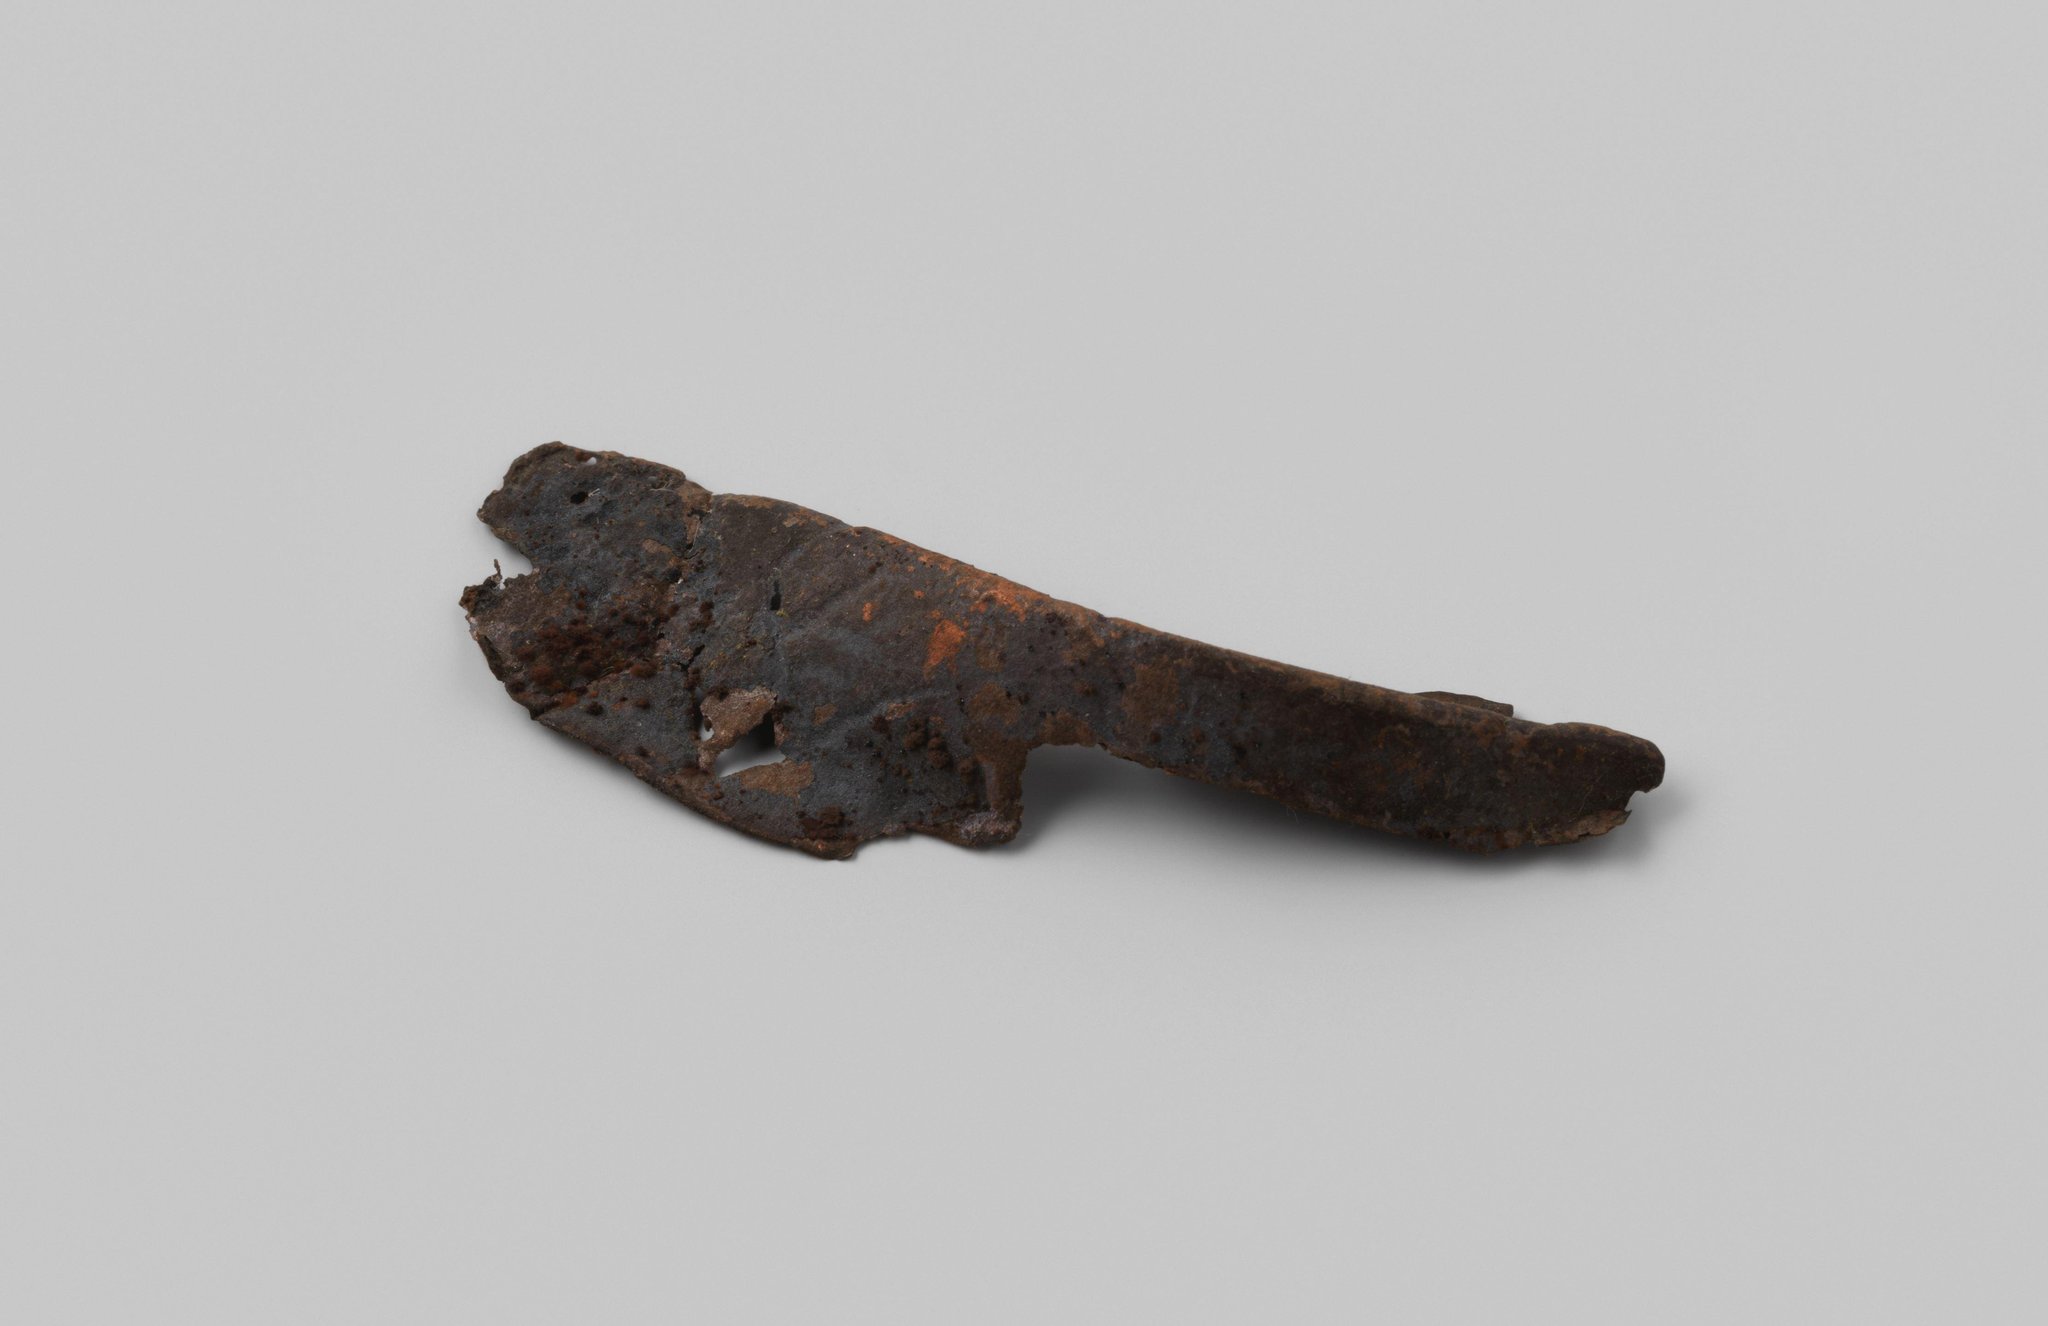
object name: fragment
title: Fragment koper uit het wrak van de Oost-Indiëvaarder Hollandia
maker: Anonymous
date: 1700-1743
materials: copper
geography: netherlands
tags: verenigde oostindische compagnie, hollandia (schip), annet